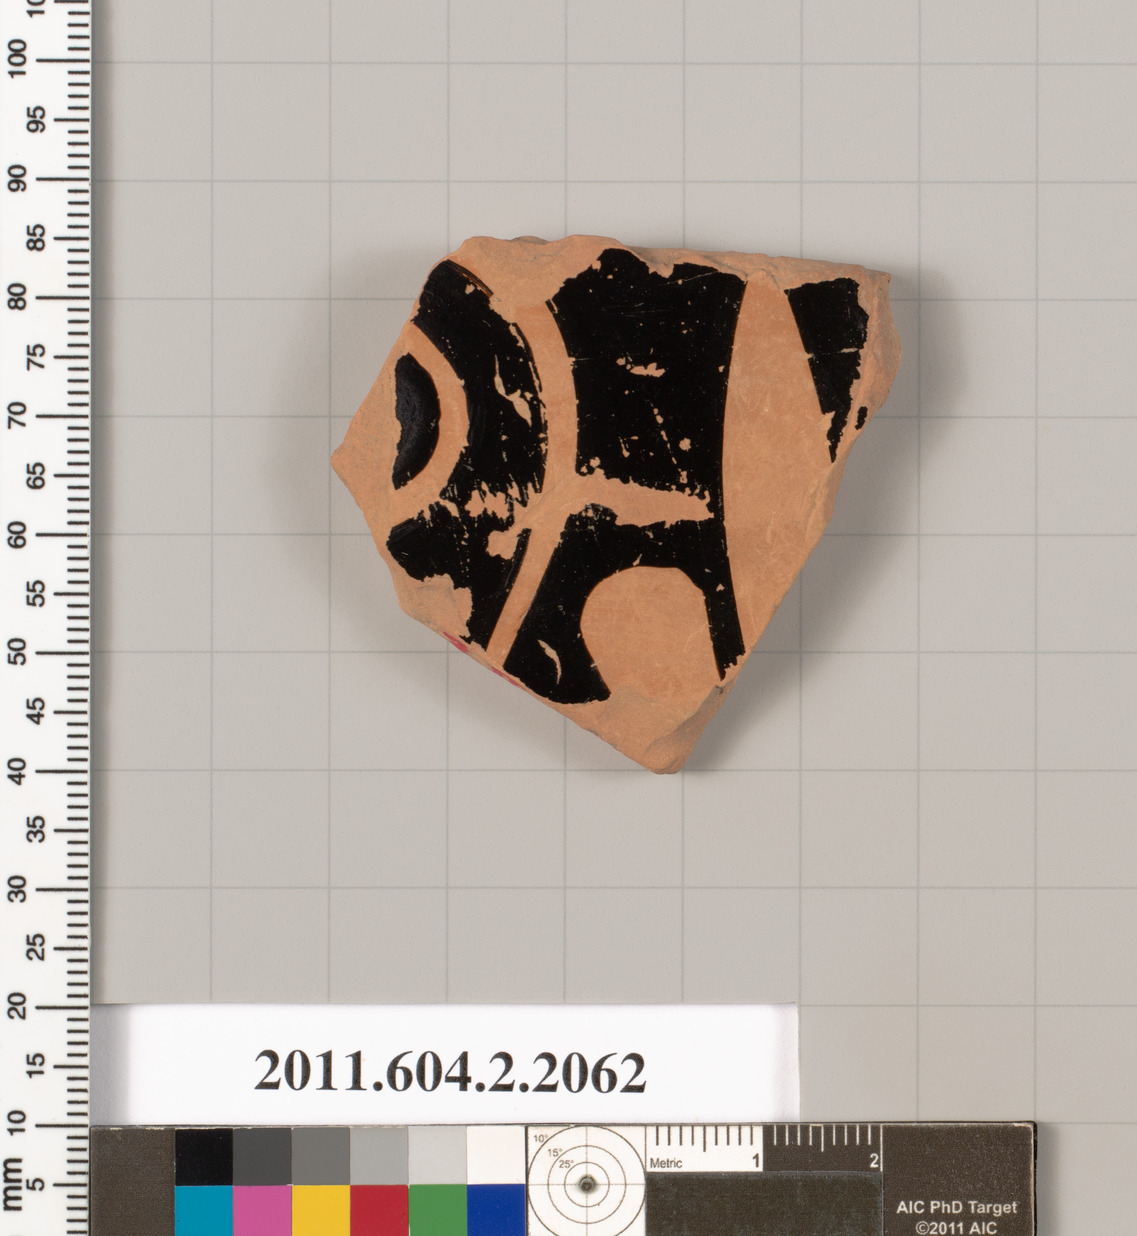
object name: krater fragment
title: Terracotta fragment of a krater (bowl for mixing wine and water)?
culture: greek, attic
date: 475-451 BCE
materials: terracotta